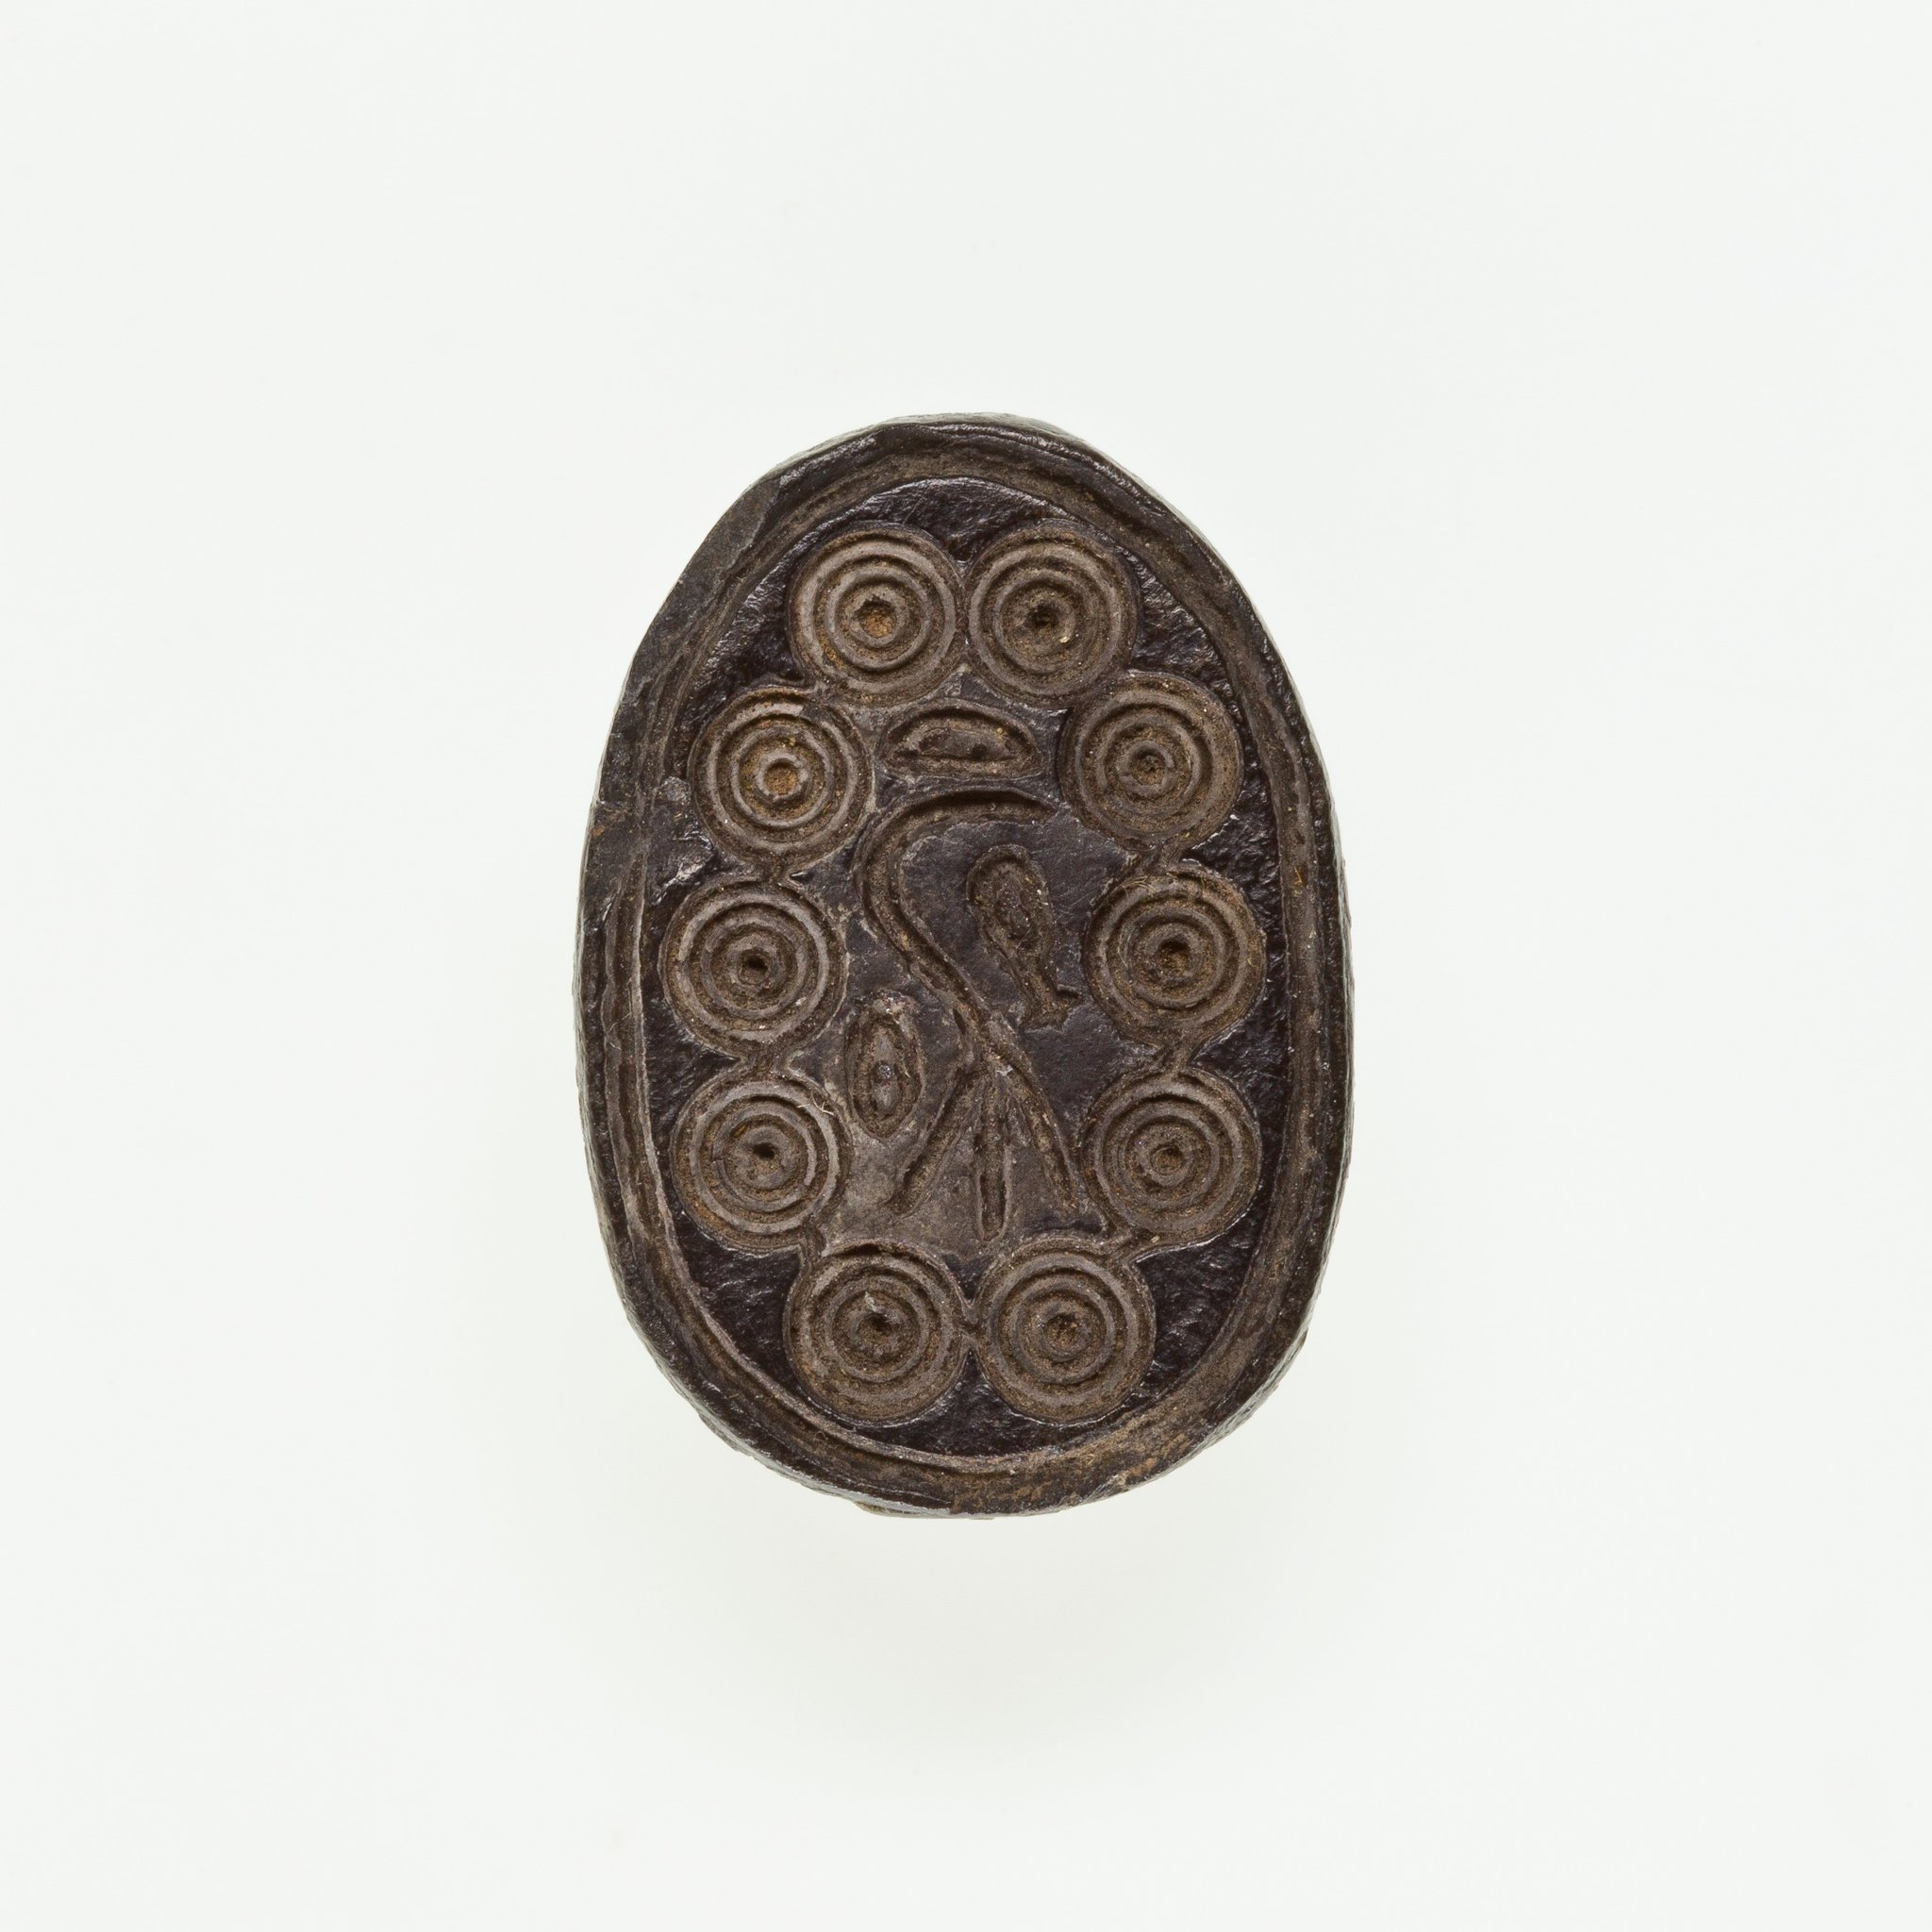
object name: scarab, lotus flower, circle border, hieroglyph, nefer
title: Scarab Incised with Hierolgyphs and Flower in Circle Border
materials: stone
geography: egypt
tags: scarabs